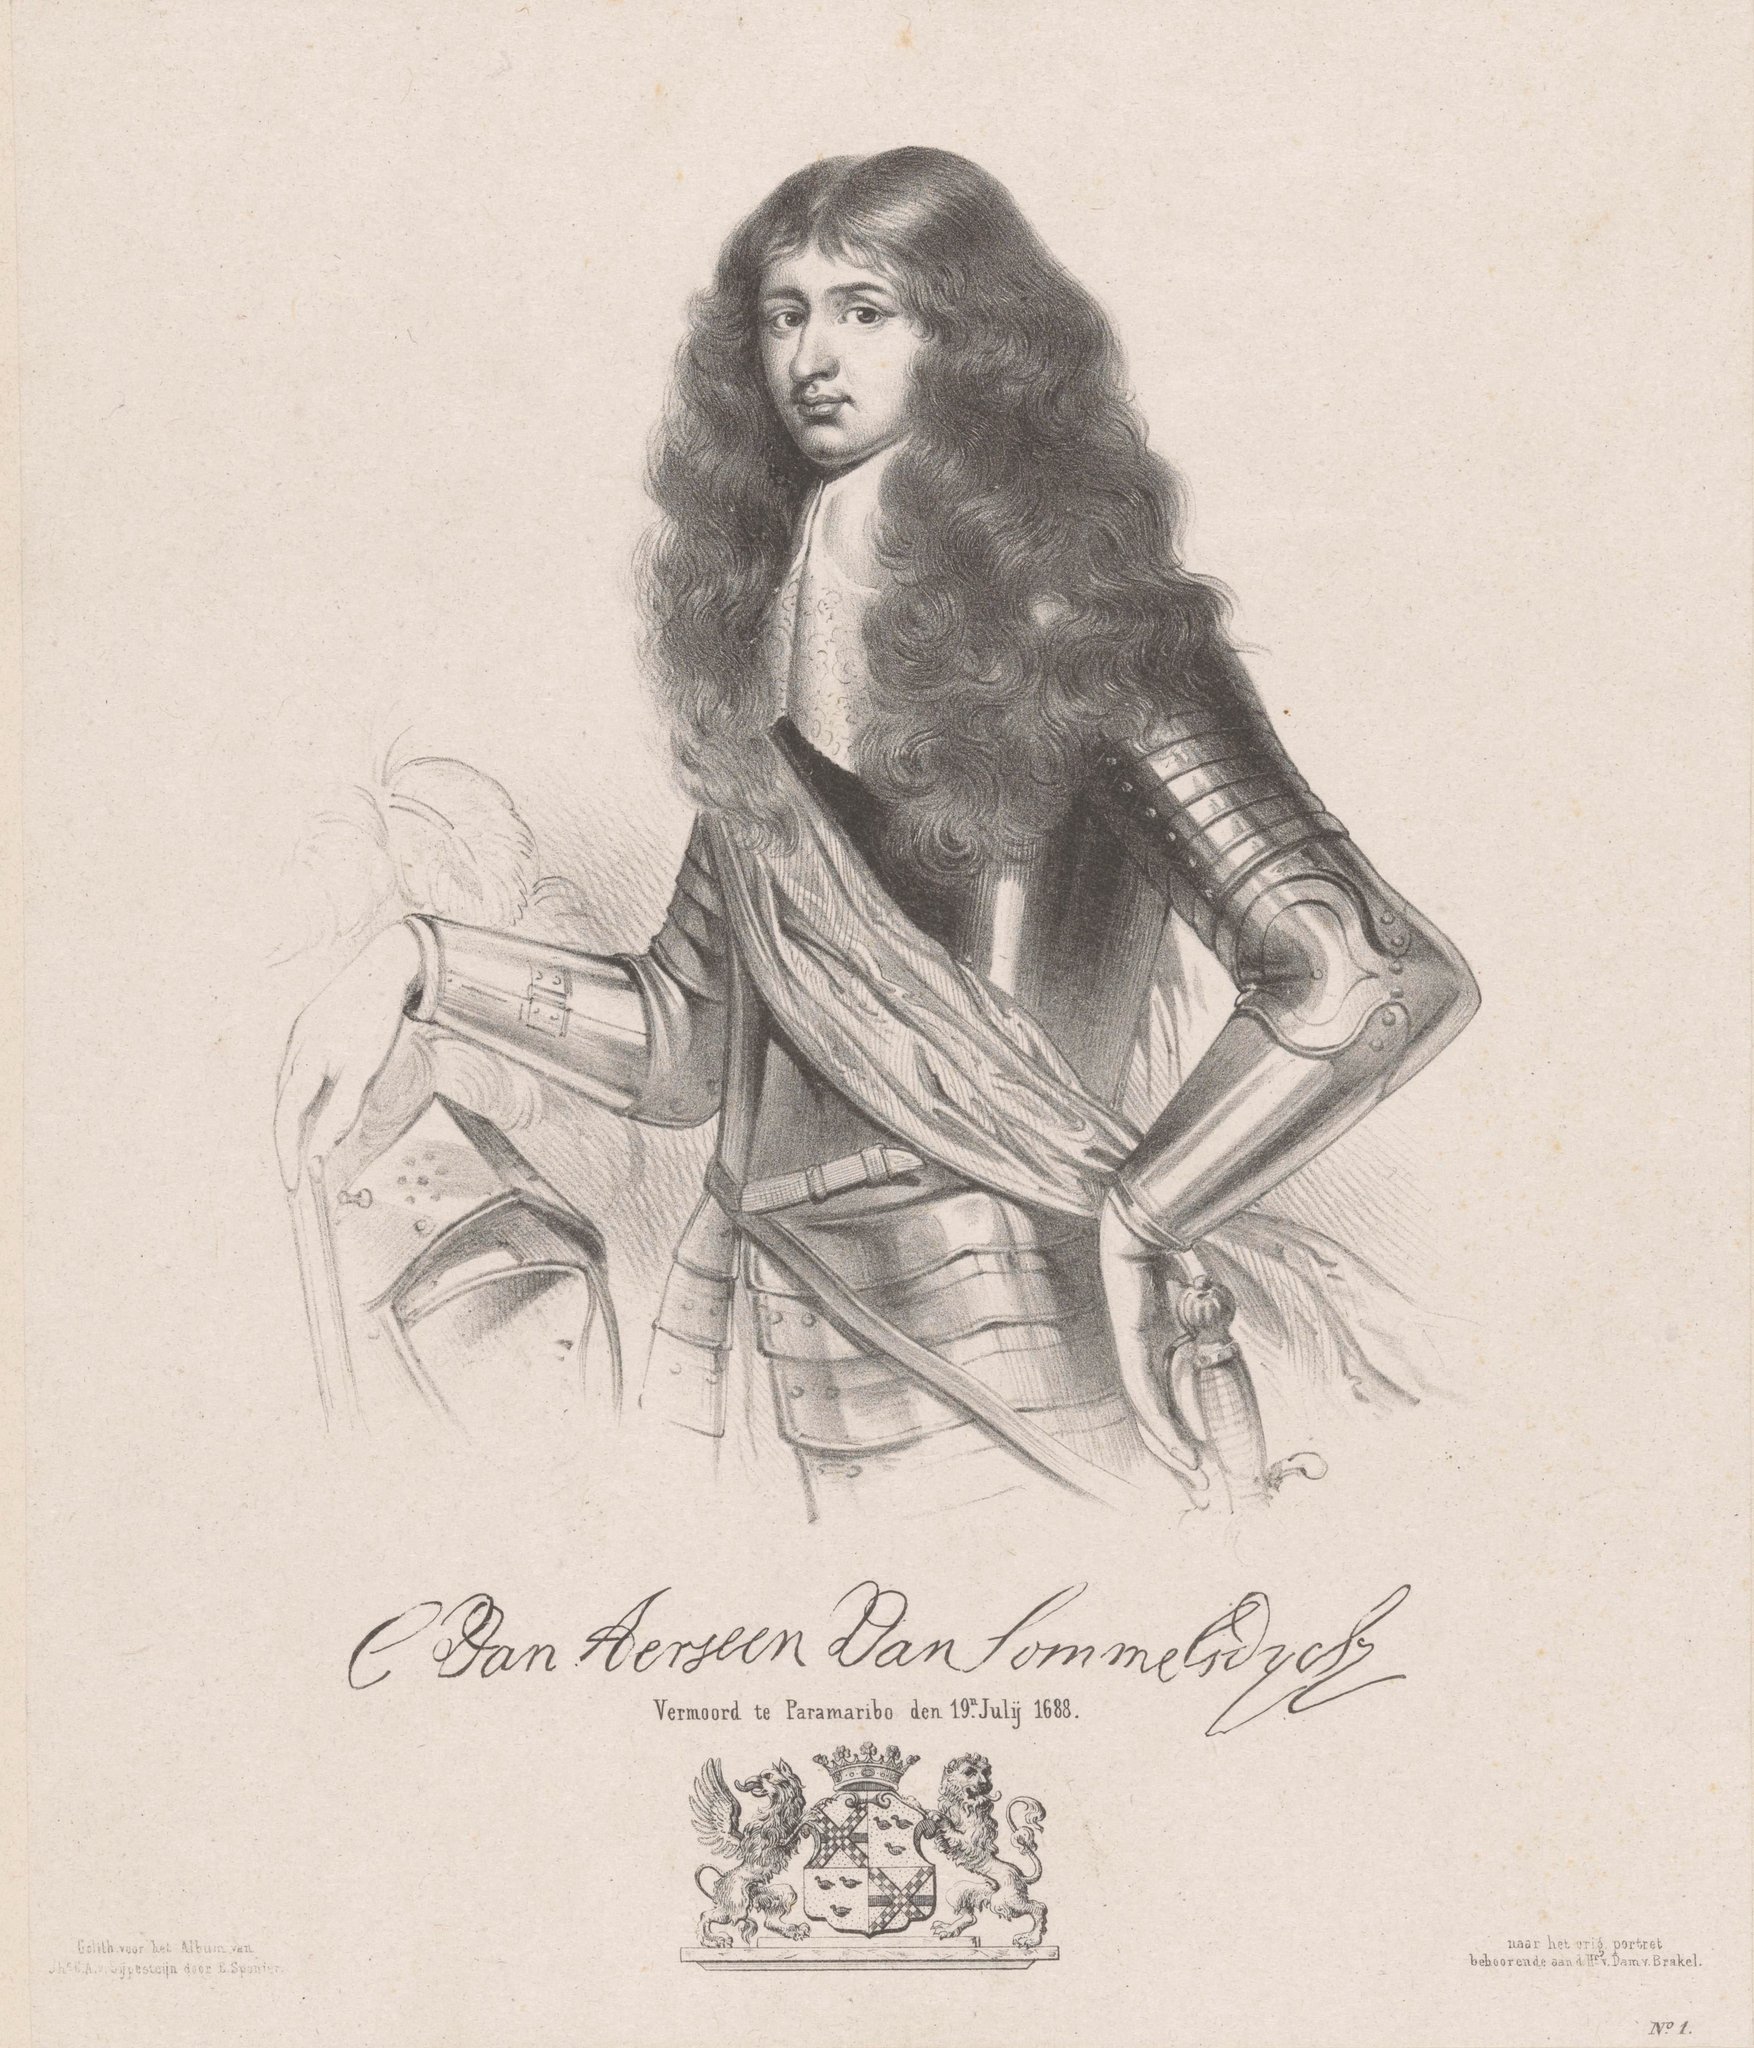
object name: print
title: Portret van Cornelis van Aerssen van Sommelsdijk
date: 1831-1863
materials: paper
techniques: lithograph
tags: cornelis van aerssen jr.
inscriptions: collector's mark: Lugt 2228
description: Portret van Cornelis van Aerssen van Sommelsdijk. Hij draagt een harnas en naast hem ligt zijn gepluimde helm. Midden onder zijn wapen. In de ondermarge zijn handtekening, zijn sterfplaats en sterfdatum. Rechtsonder: No. 1.